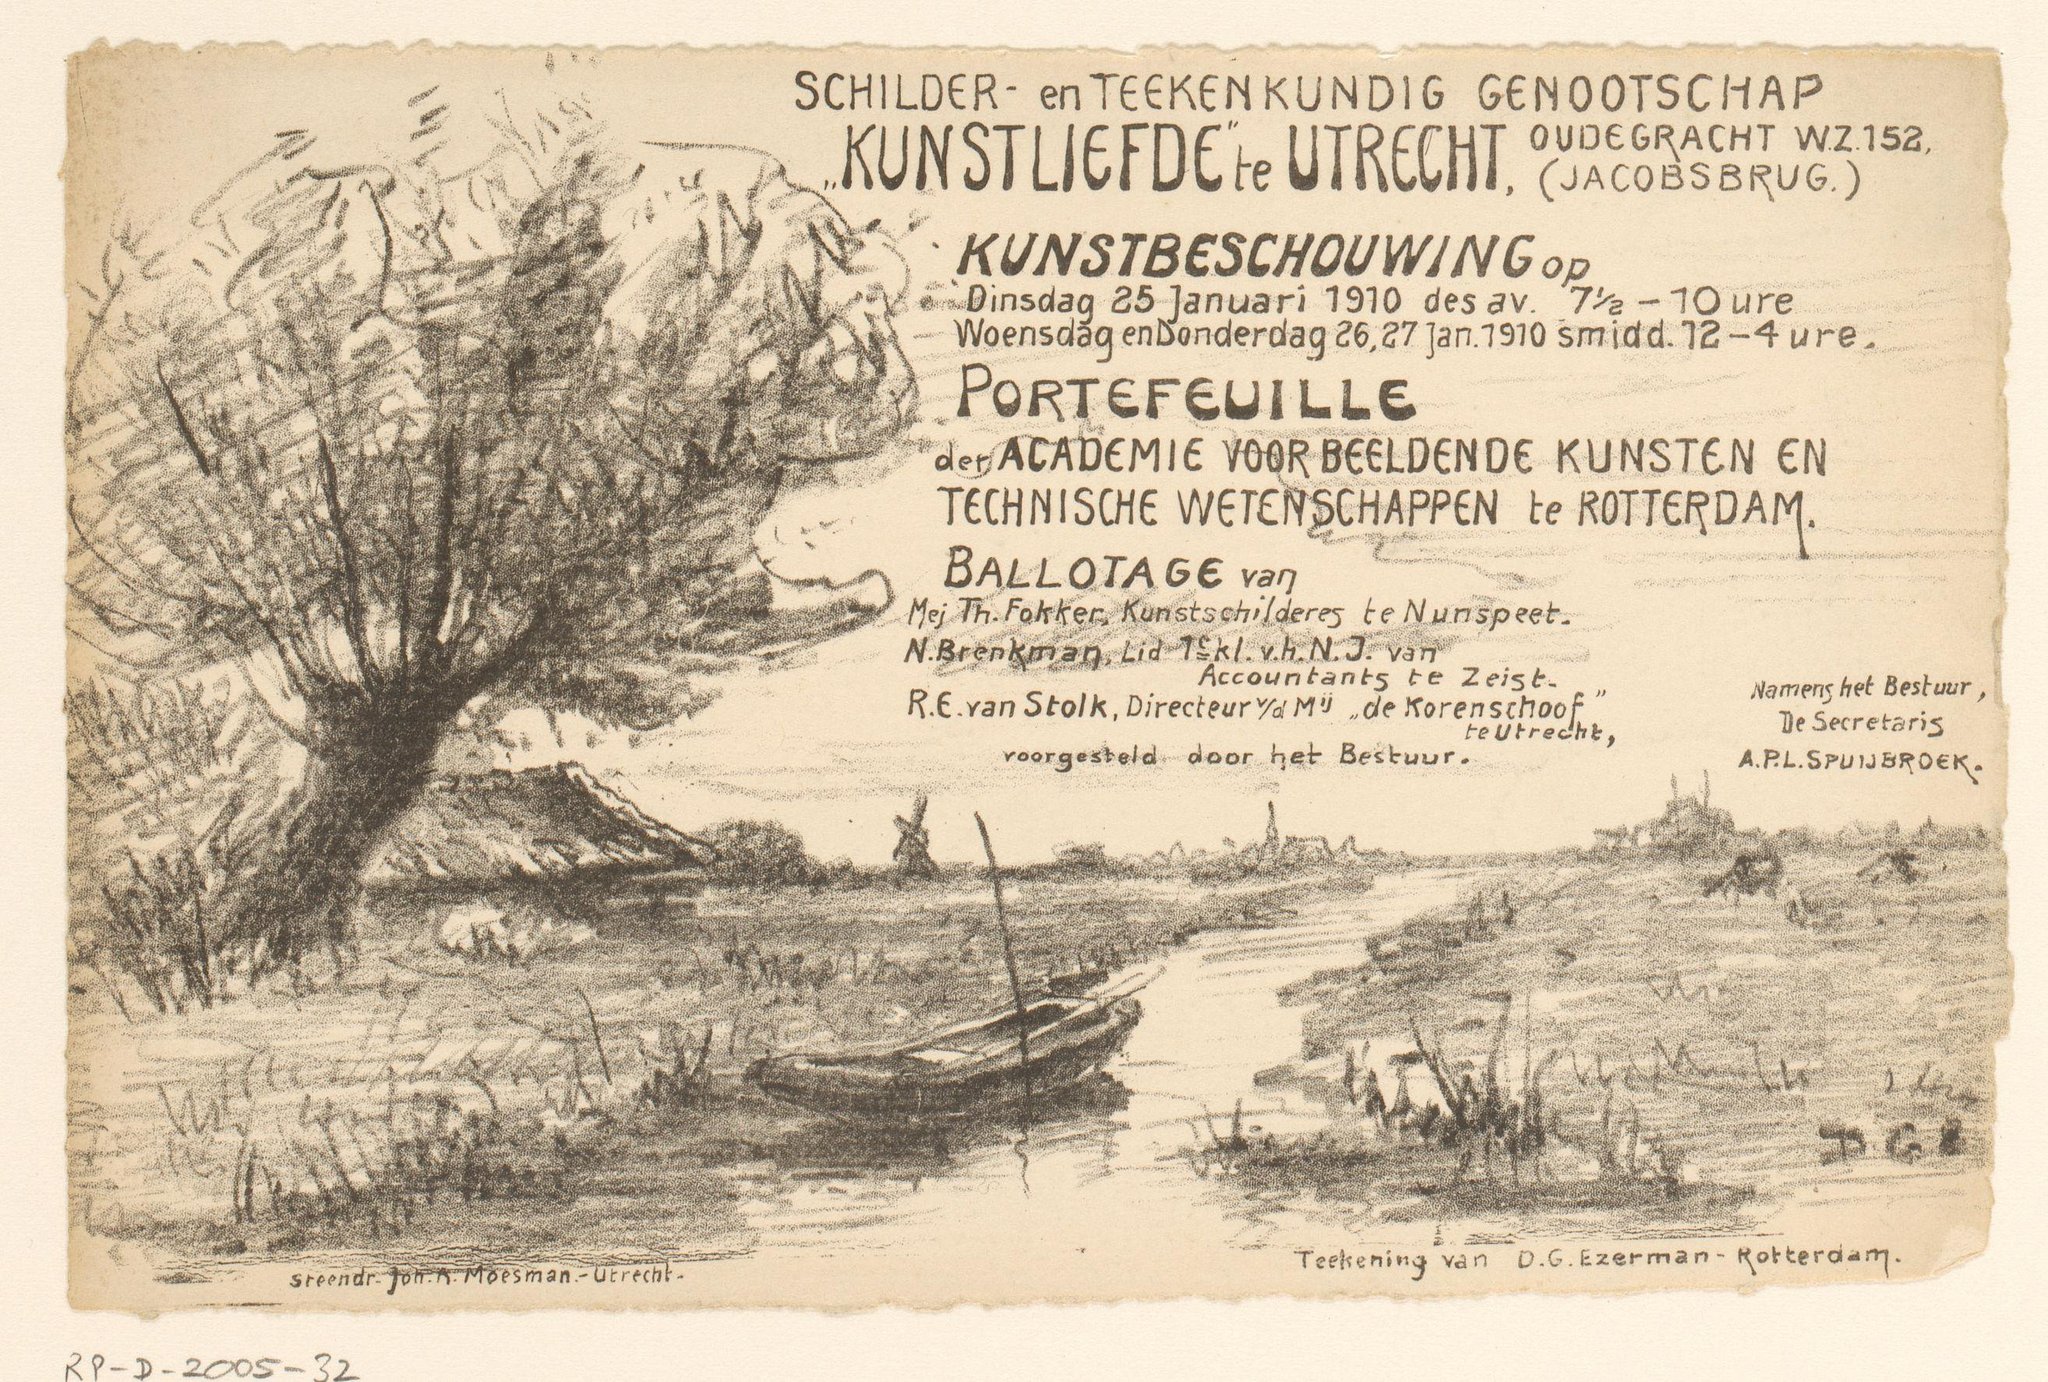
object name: invitation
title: Uitnodiging van Schilder- en Teekenkundig Genootschap "Kunstliefde" voor een kunstbeschouwing, 25-27 januari 1910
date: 1901-1910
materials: paper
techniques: lithograph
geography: utrecht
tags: criticizing and discussing art, art criticism, circle, club of artists, collecting and exhibiting products of the fine arts, meadow, pasture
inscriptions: collector's mark: Lugt 2228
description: Landschap met weilanden en sloot. Uitnodiging van Schilder- en Teekenkundig Genootschap "Kunstliefde" voor een kunstbeschouwing op 25-27 januari 1910 van de portefeuille van de Academie van Beeldende Kunsten en Technische Wetenschappen te Rotterdam.